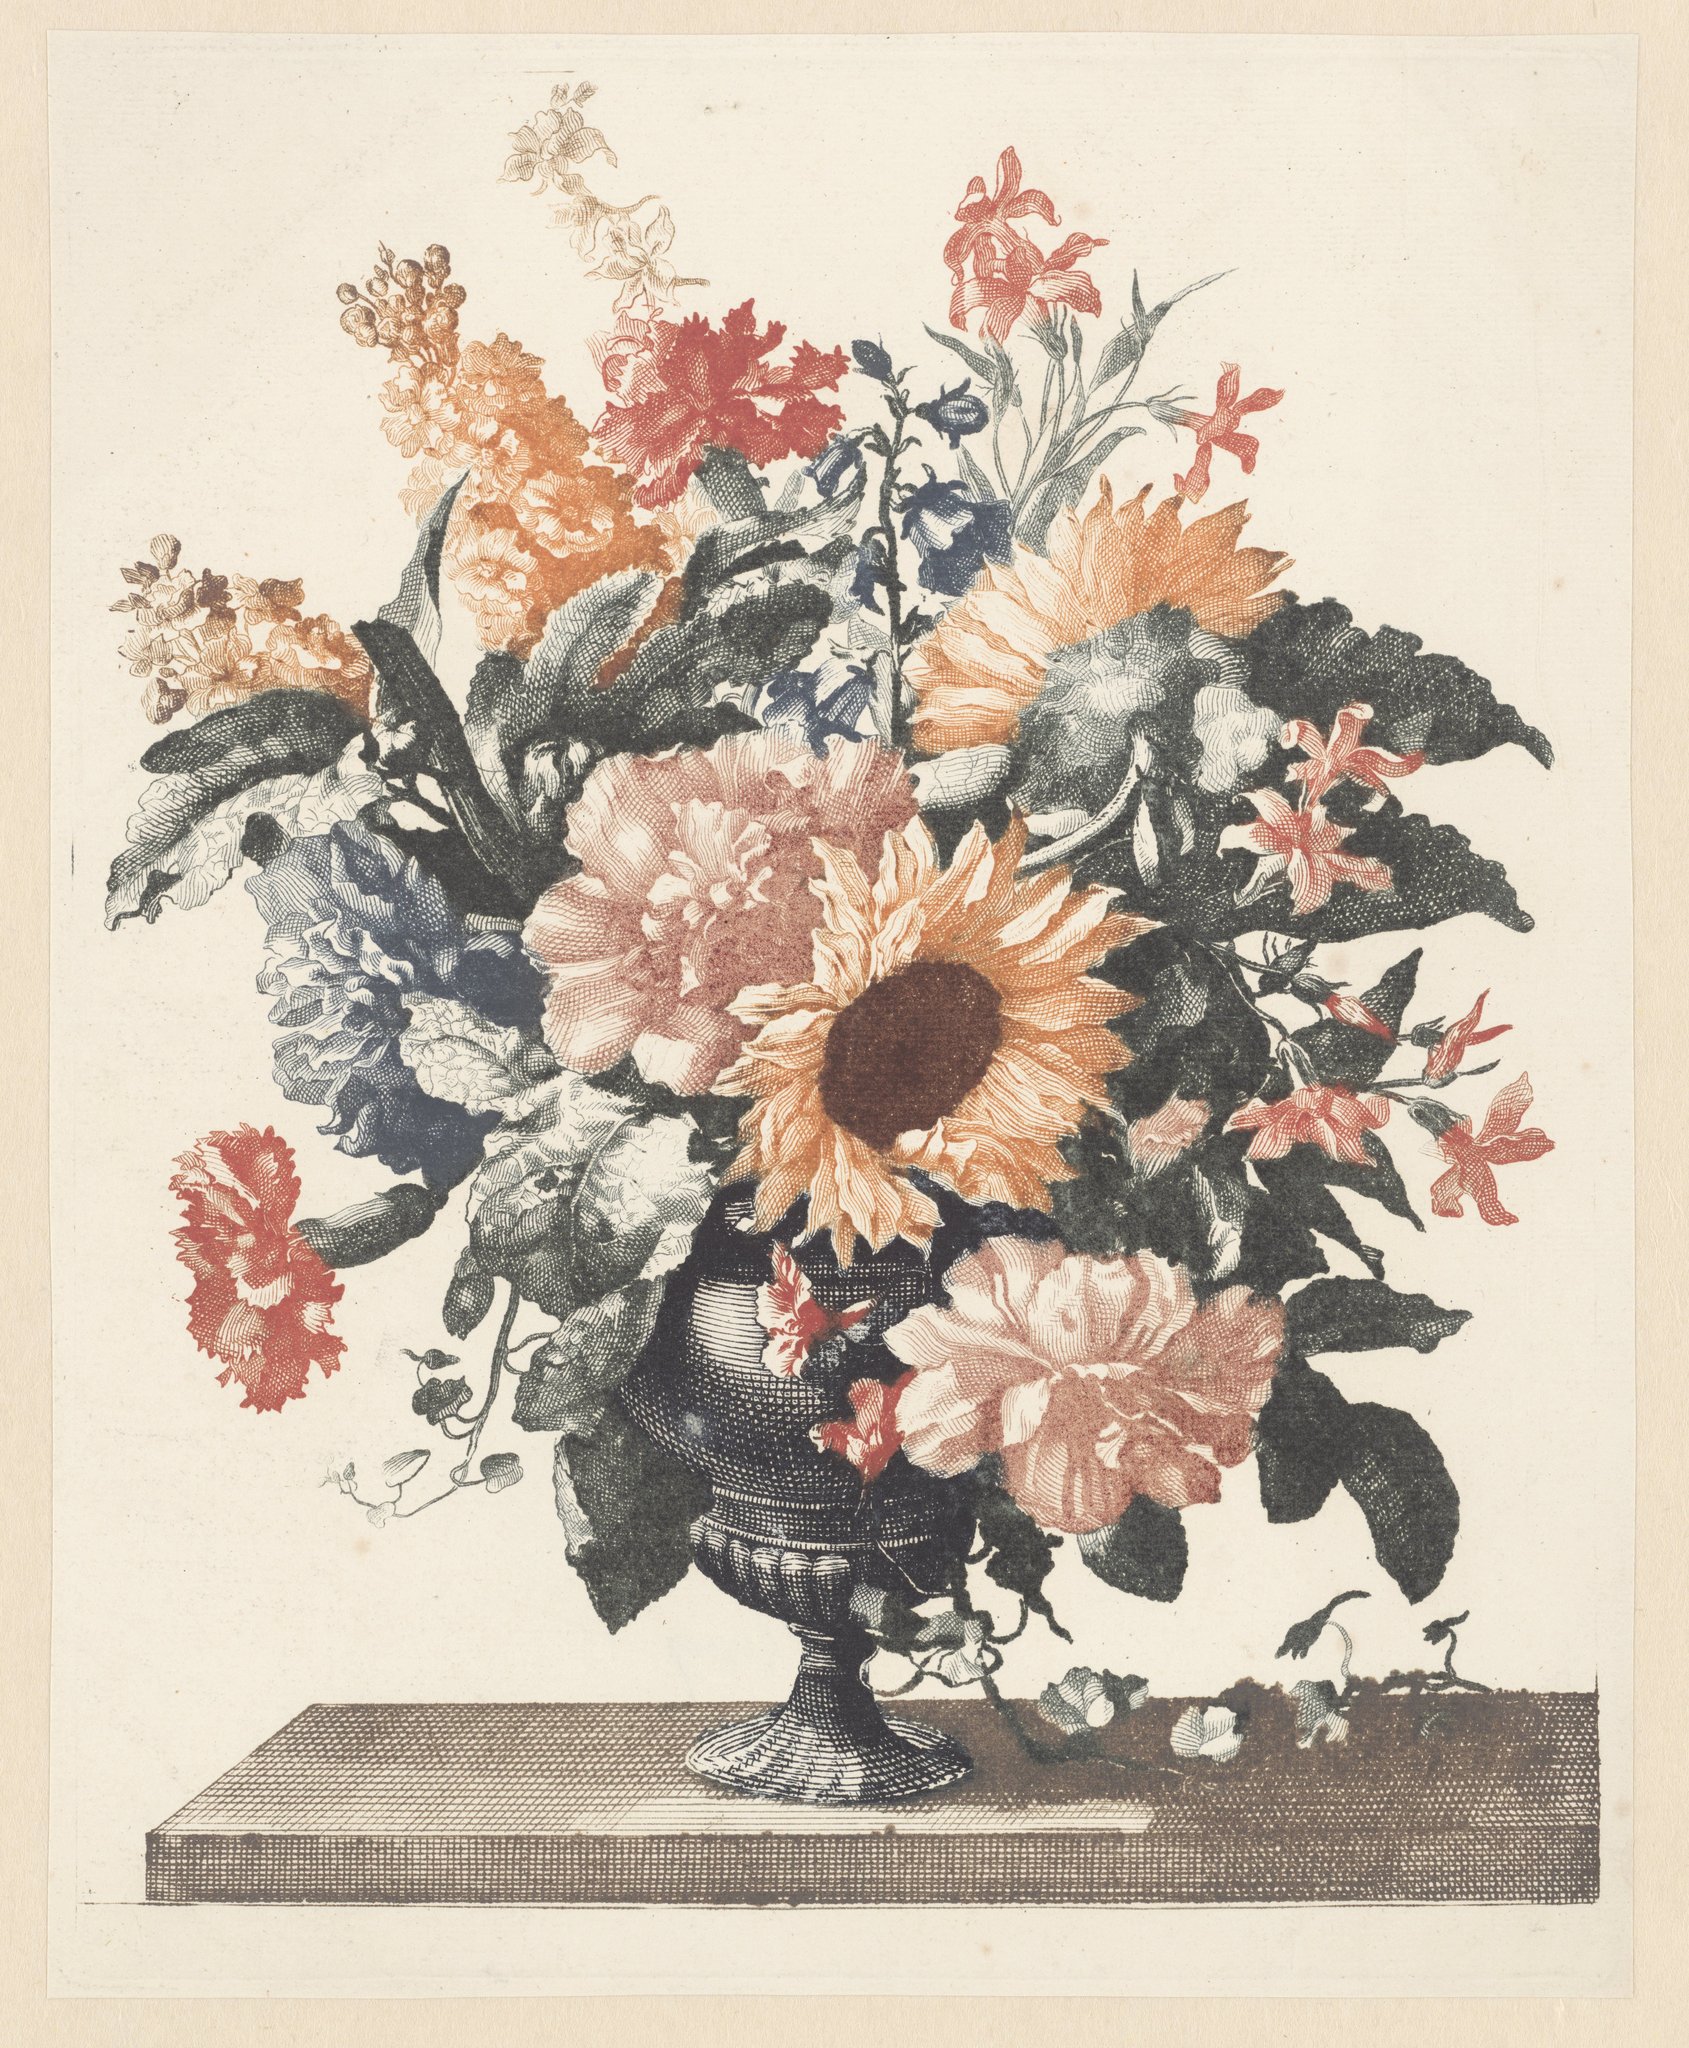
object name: print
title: Stenen vaas met onder andere zonnebloemen en anjers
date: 1688-1698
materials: paper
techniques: engraving, etching, lithography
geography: netherlands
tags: flowers in a vase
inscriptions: collector's mark: Lugt 2228